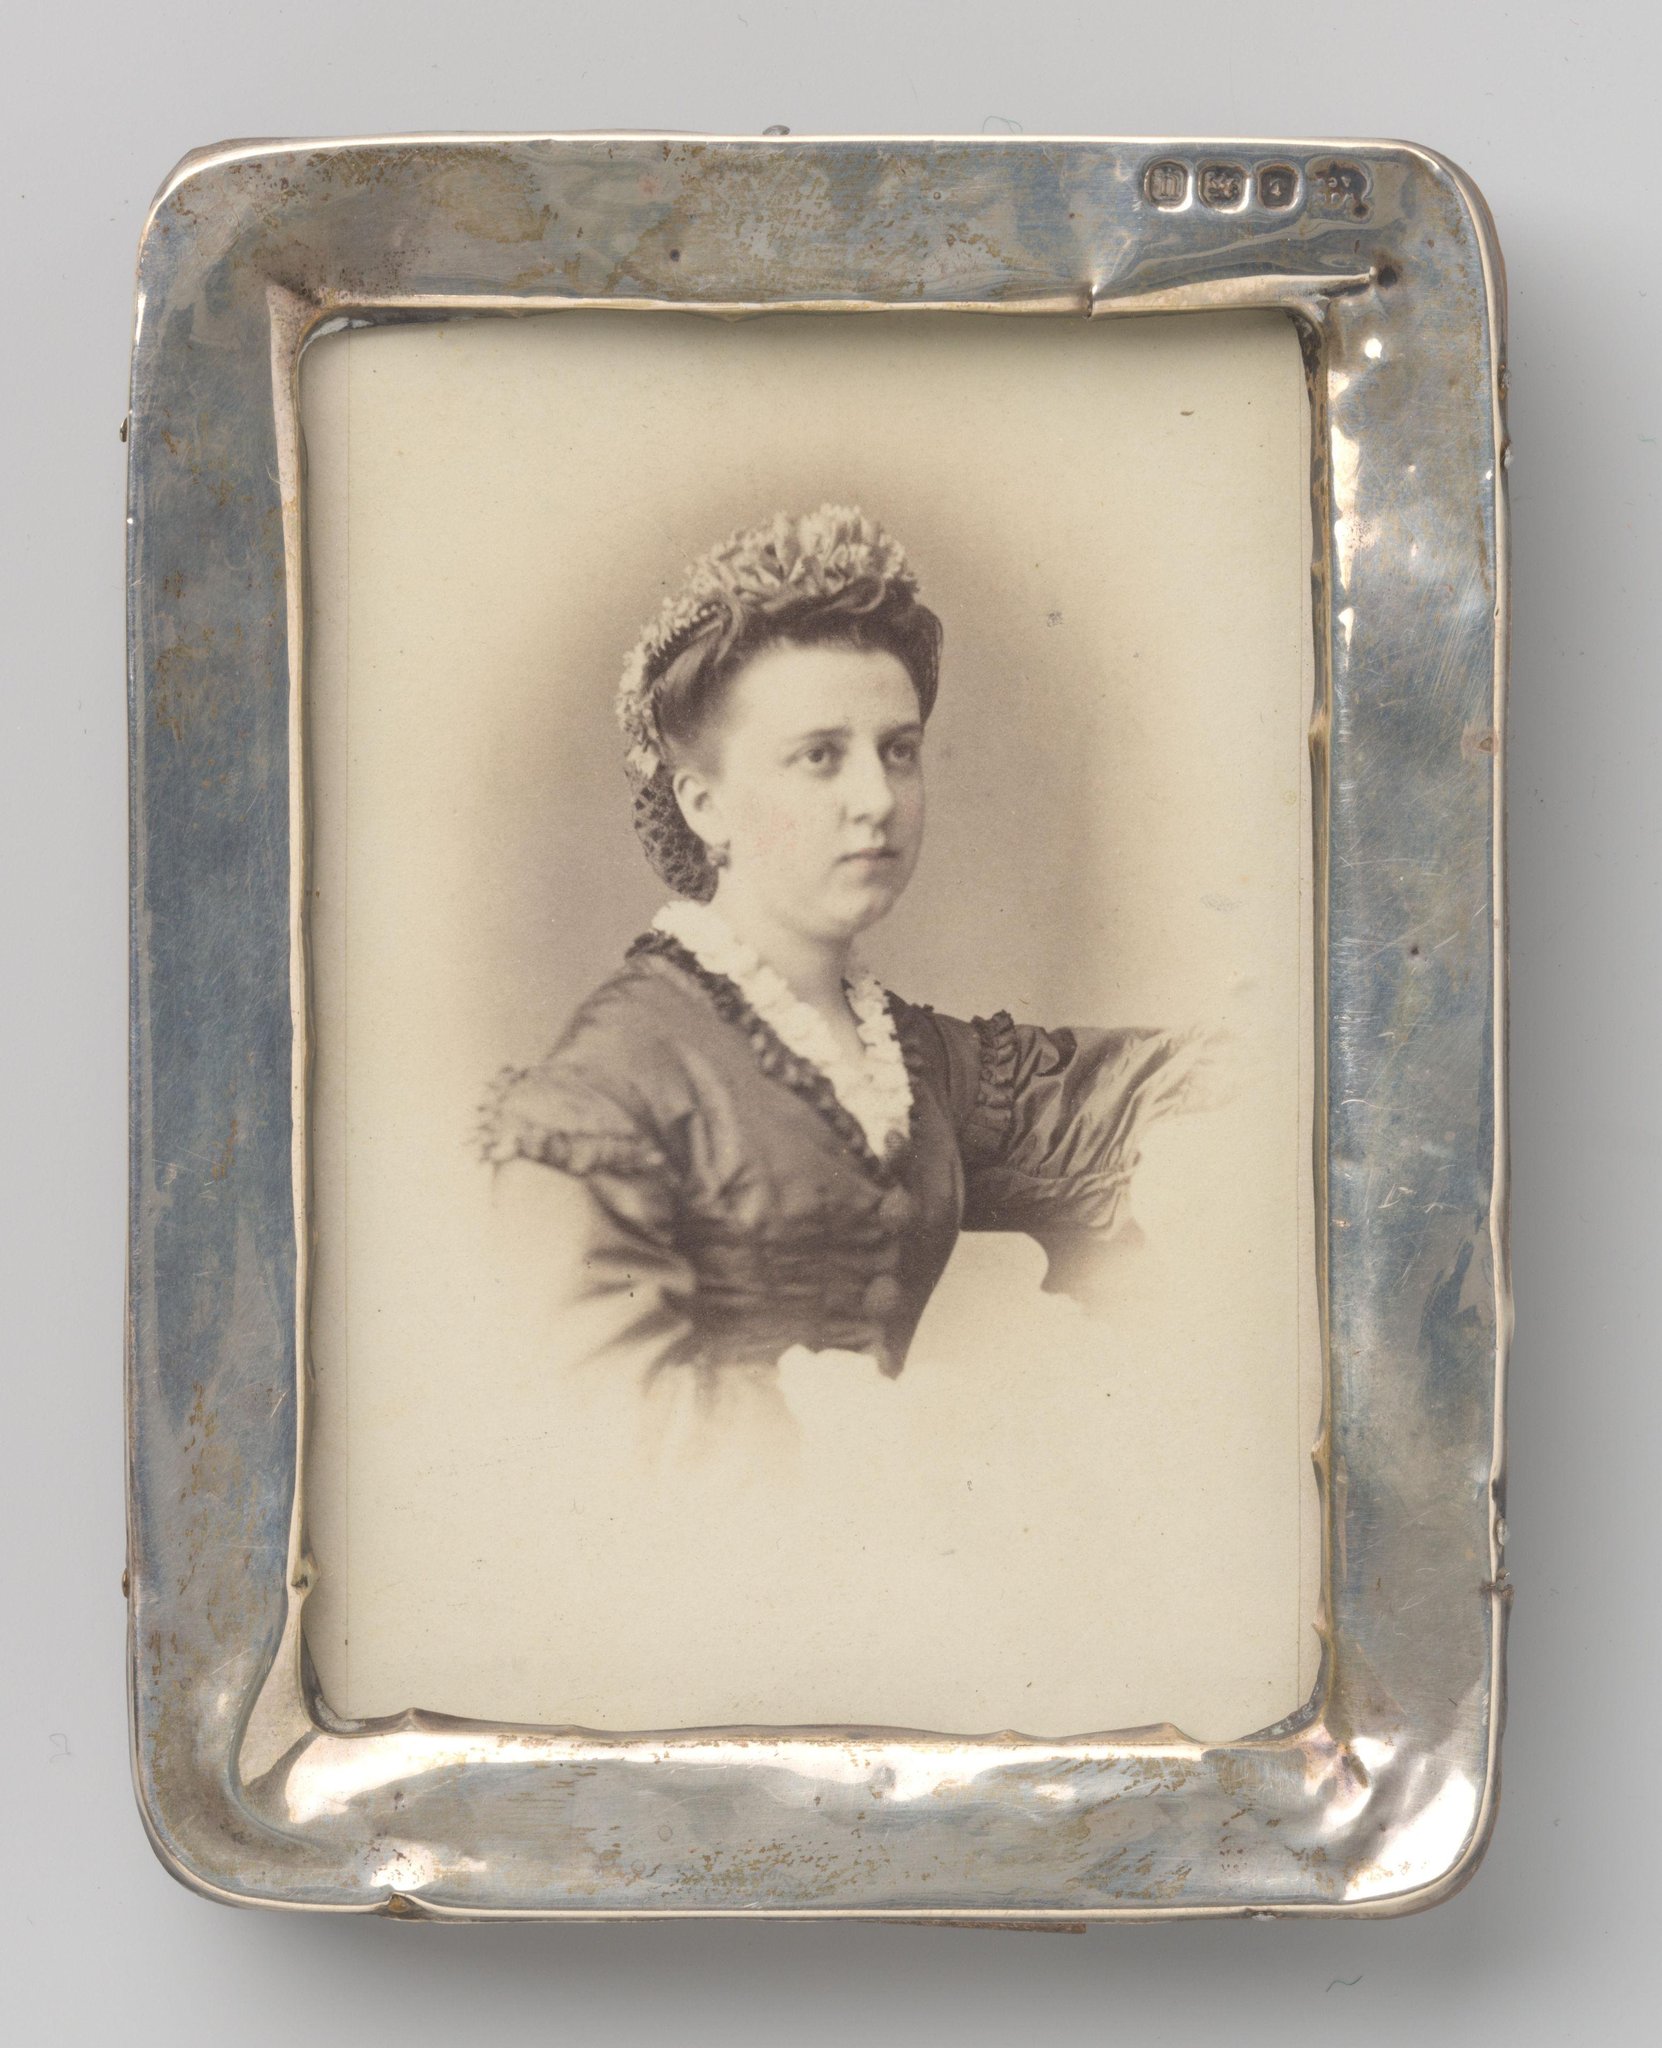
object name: photograph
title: Portret van een onbekende vrouw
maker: Anonymous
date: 1880-1900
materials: cardboard, glass, metal, paper, wood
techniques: albumen print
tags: adult woman, anonymous historical person portrayed